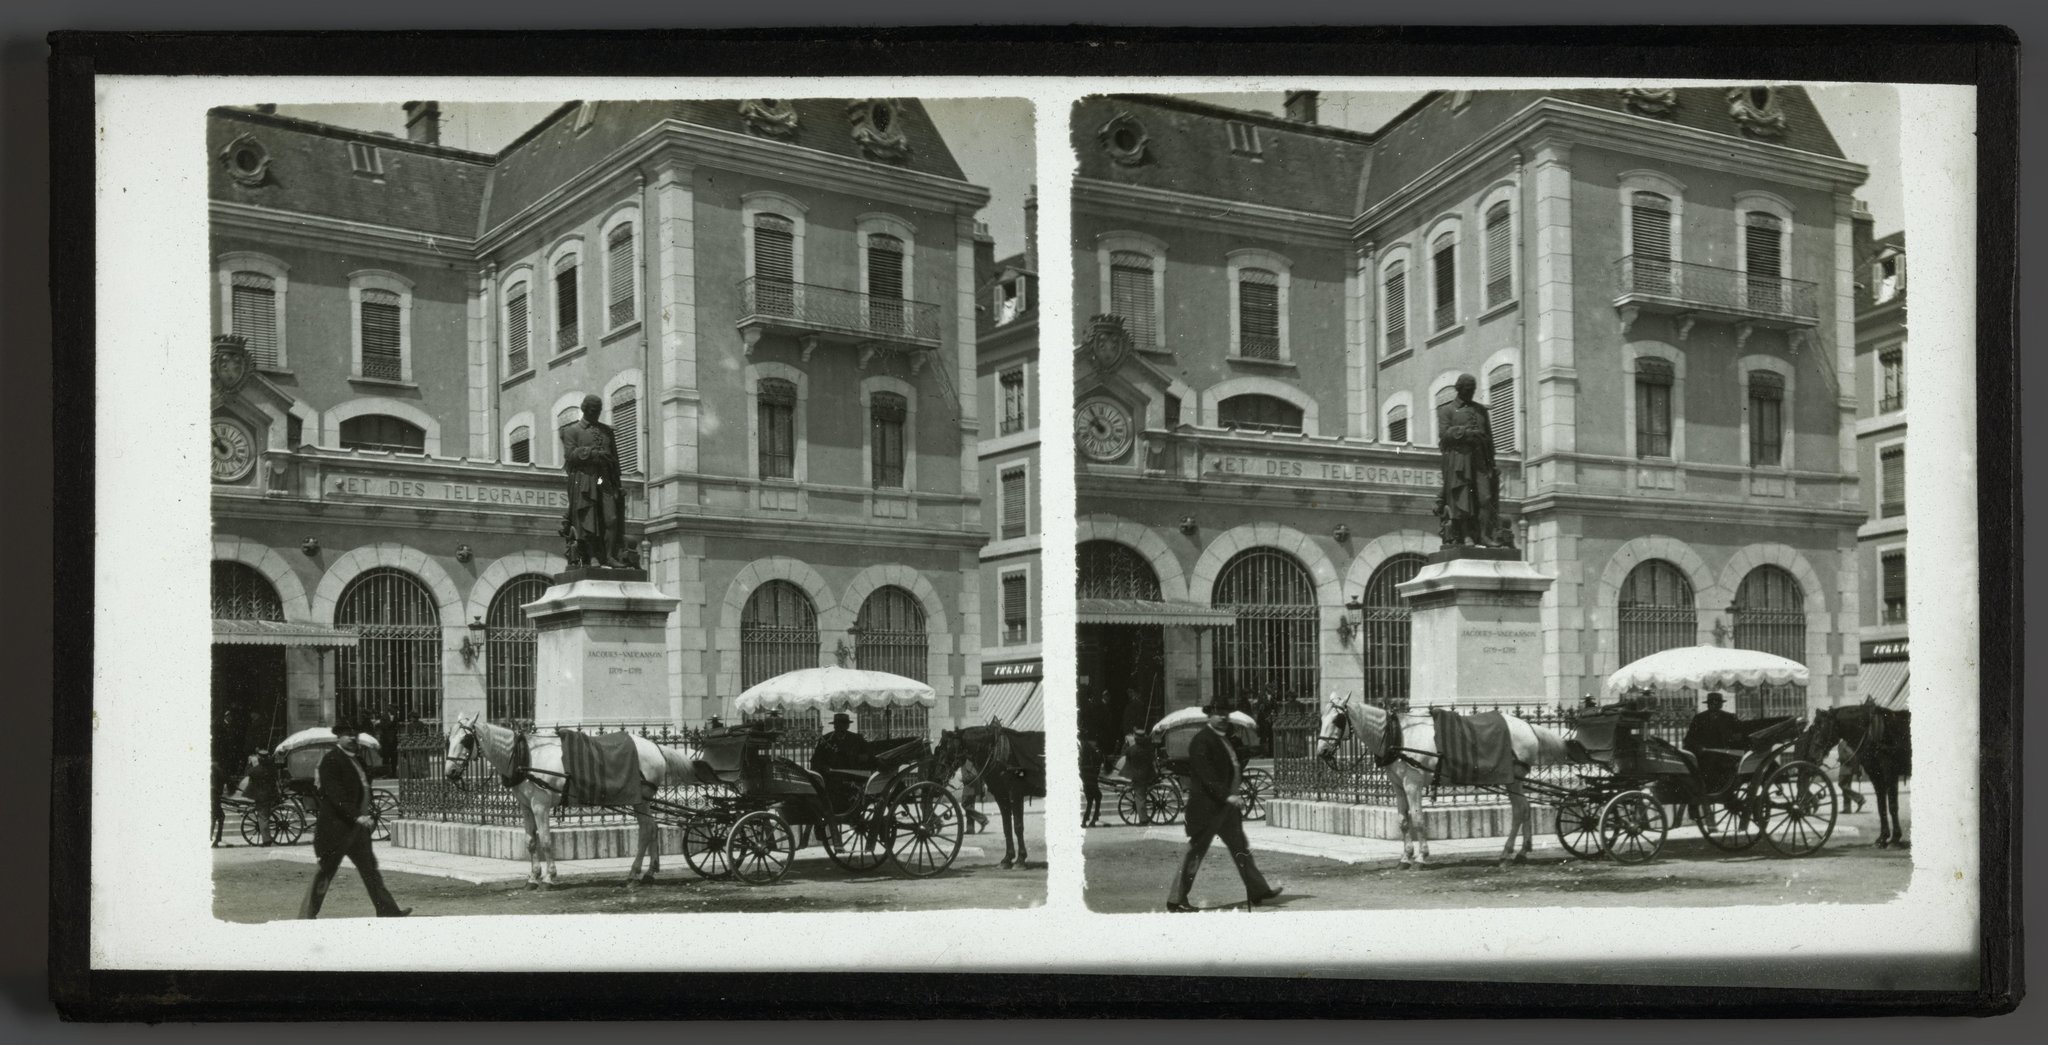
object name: stereoscopic photograph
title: Standbeeld van Jacques de Vaucanson te Grenoble, Frankrijk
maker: Anonymous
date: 1860-1890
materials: glass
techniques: slide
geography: grenoble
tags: paris, engineer, square, place, circus, etc., monument, statue